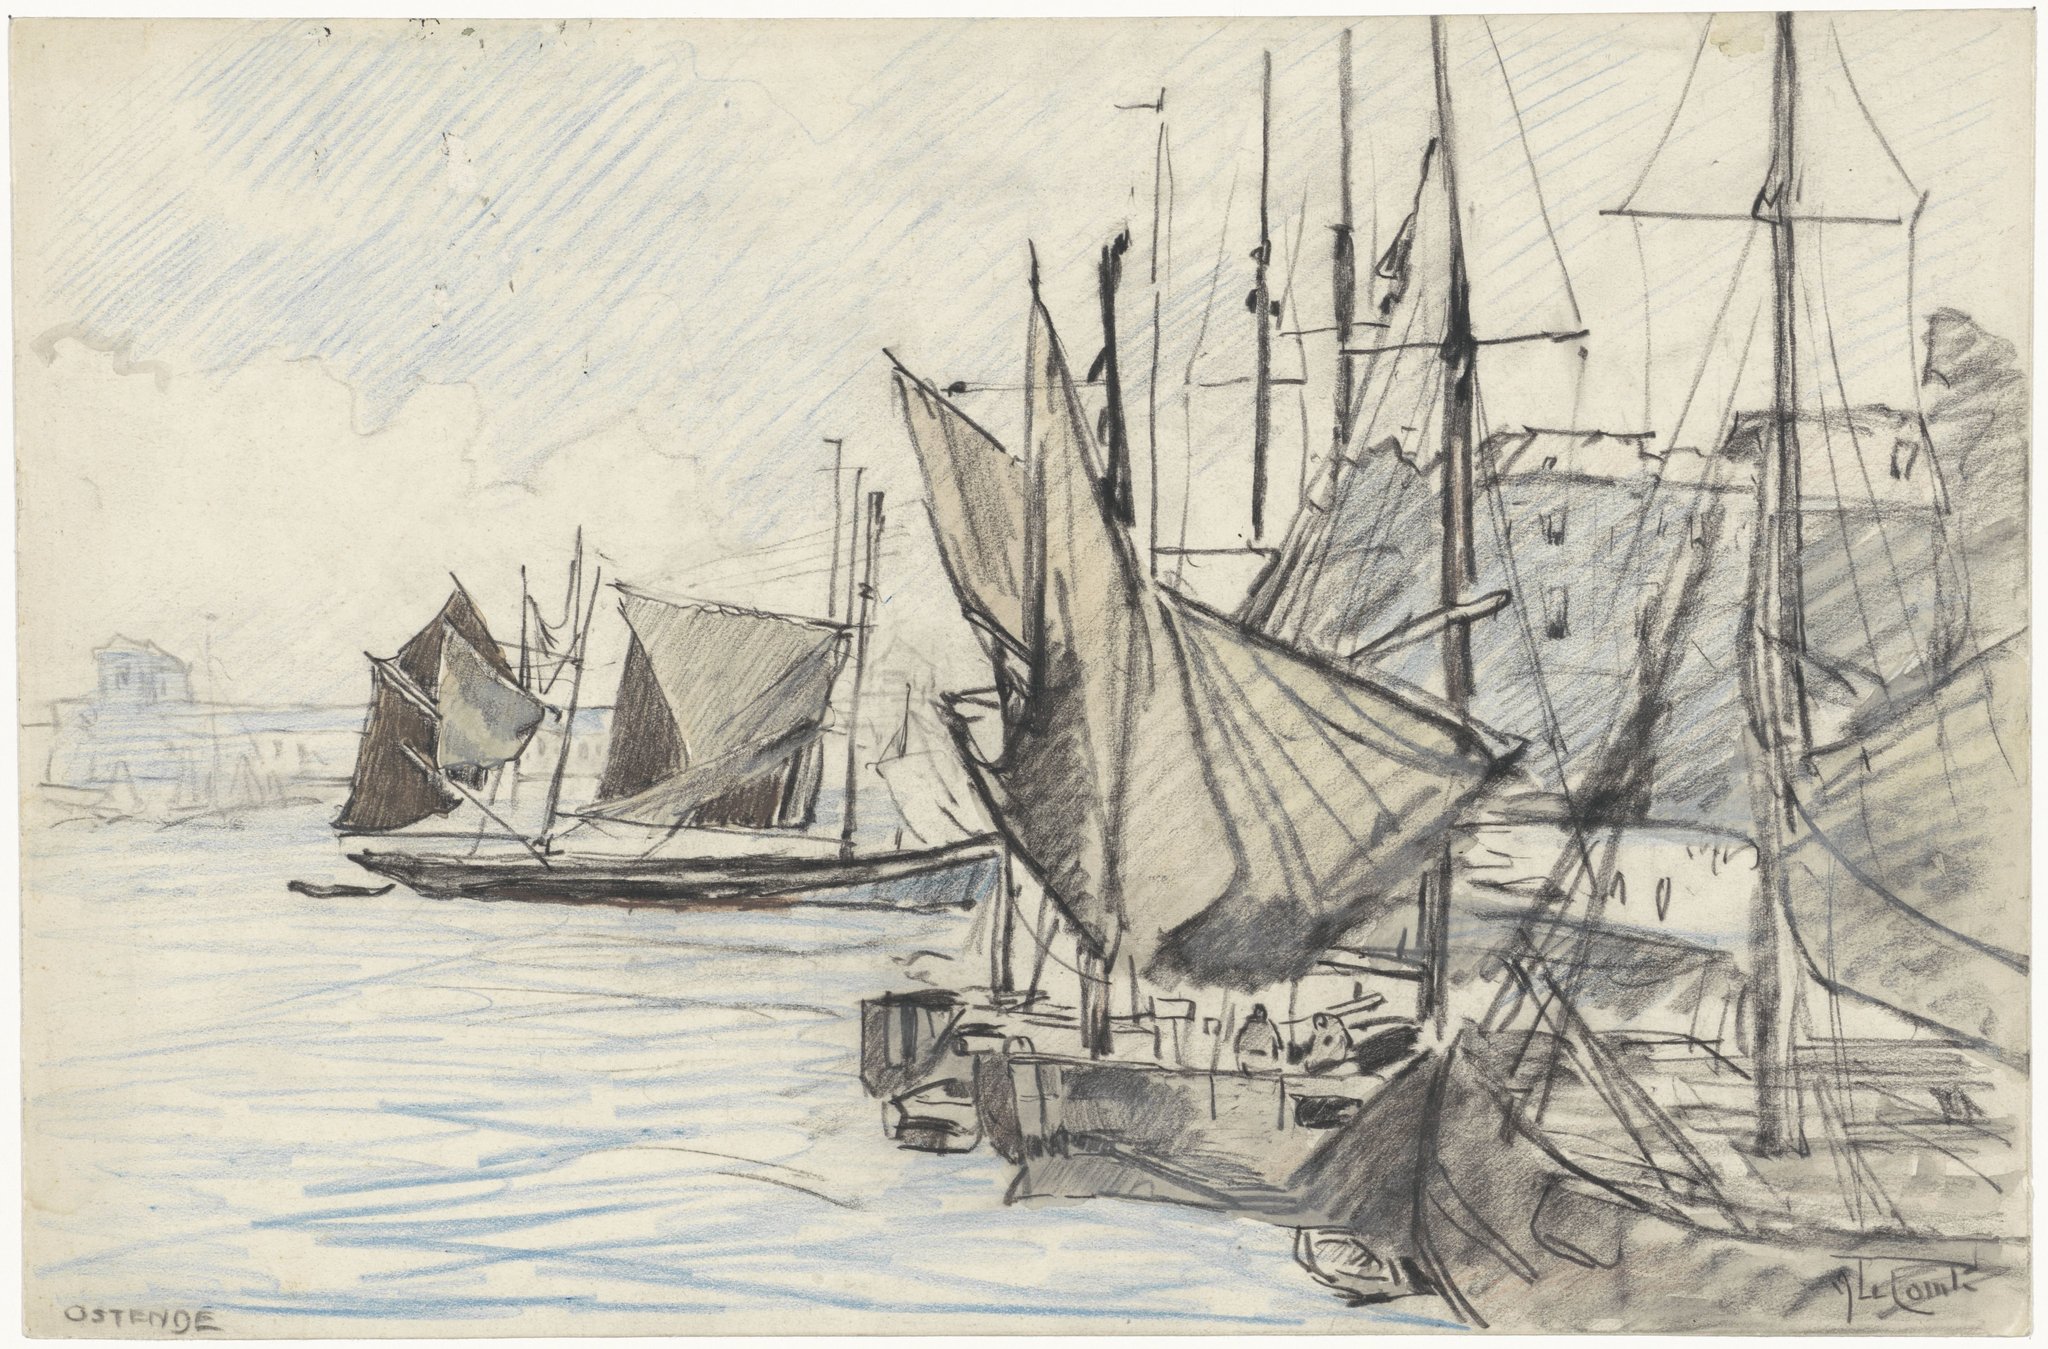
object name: drawing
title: Zeilschepen in de haven van Oostende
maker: adolf le comte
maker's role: draughtsman, painter, print maker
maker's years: 1850-1921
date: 1860-1921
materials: chalk, paper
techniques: brush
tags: harbour, belgium